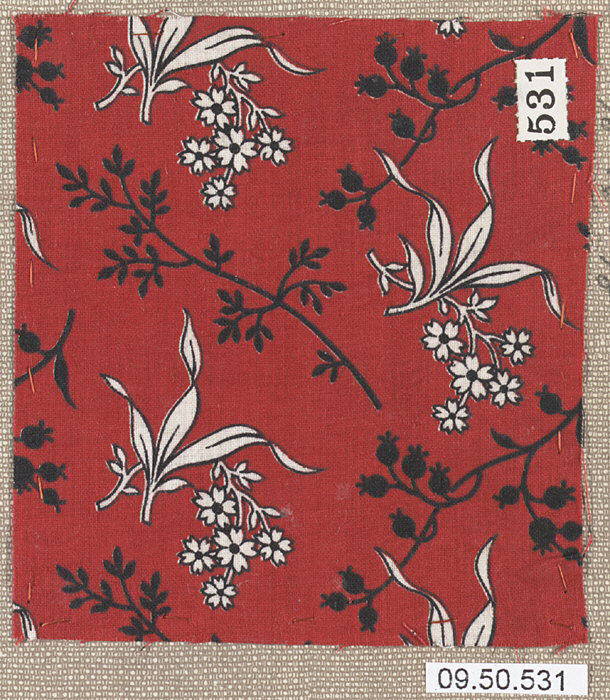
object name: piece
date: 1801-1900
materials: cotton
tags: flowers,leaves